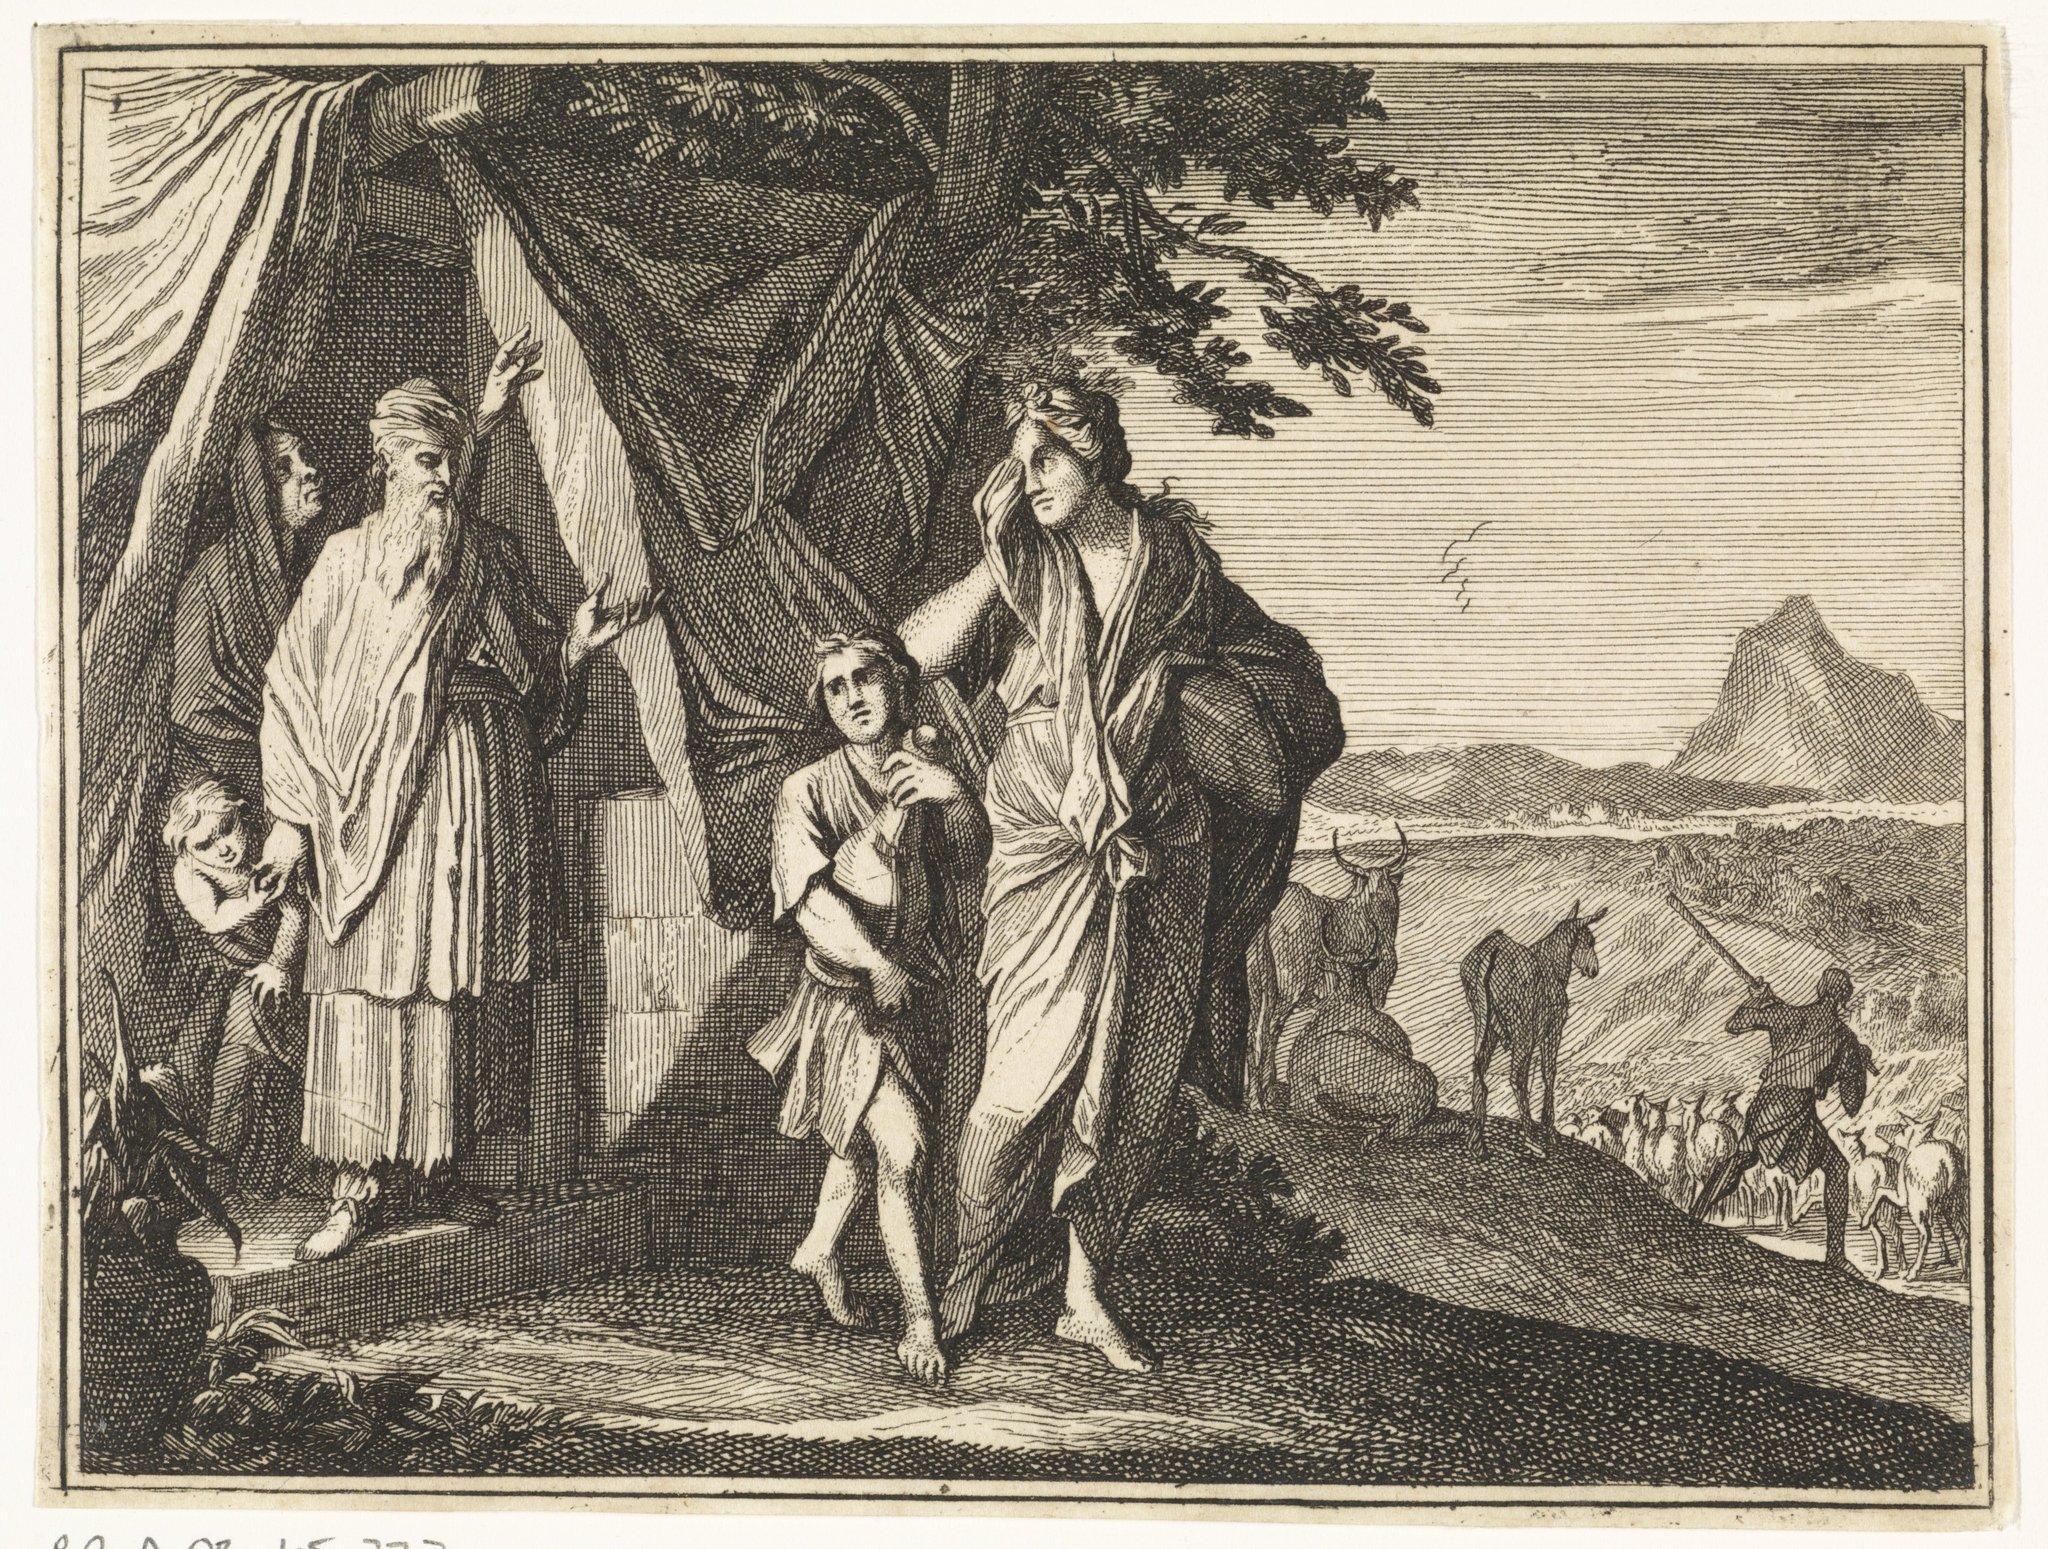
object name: print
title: Abraham verstoot Hagar en Ismaël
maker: caspar luyken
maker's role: draughtsman, print maker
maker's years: 1672-1708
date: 1712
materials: paper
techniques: etching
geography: amsterdam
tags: the banishment of hagar and ishmael (genesis 21:9-21)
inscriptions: number: ‘23’, collector's mark: Lugt 2228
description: Illustratie uit: Luyken, Jan. De schriftuurlyke geschiedenissen en gelykenissen van het Oude en Nieuwe Verbond, 2 delen. Amsterdam: Wed. Pieter Arentsz II en Cornelis van der Sys, 1712, dl. I.